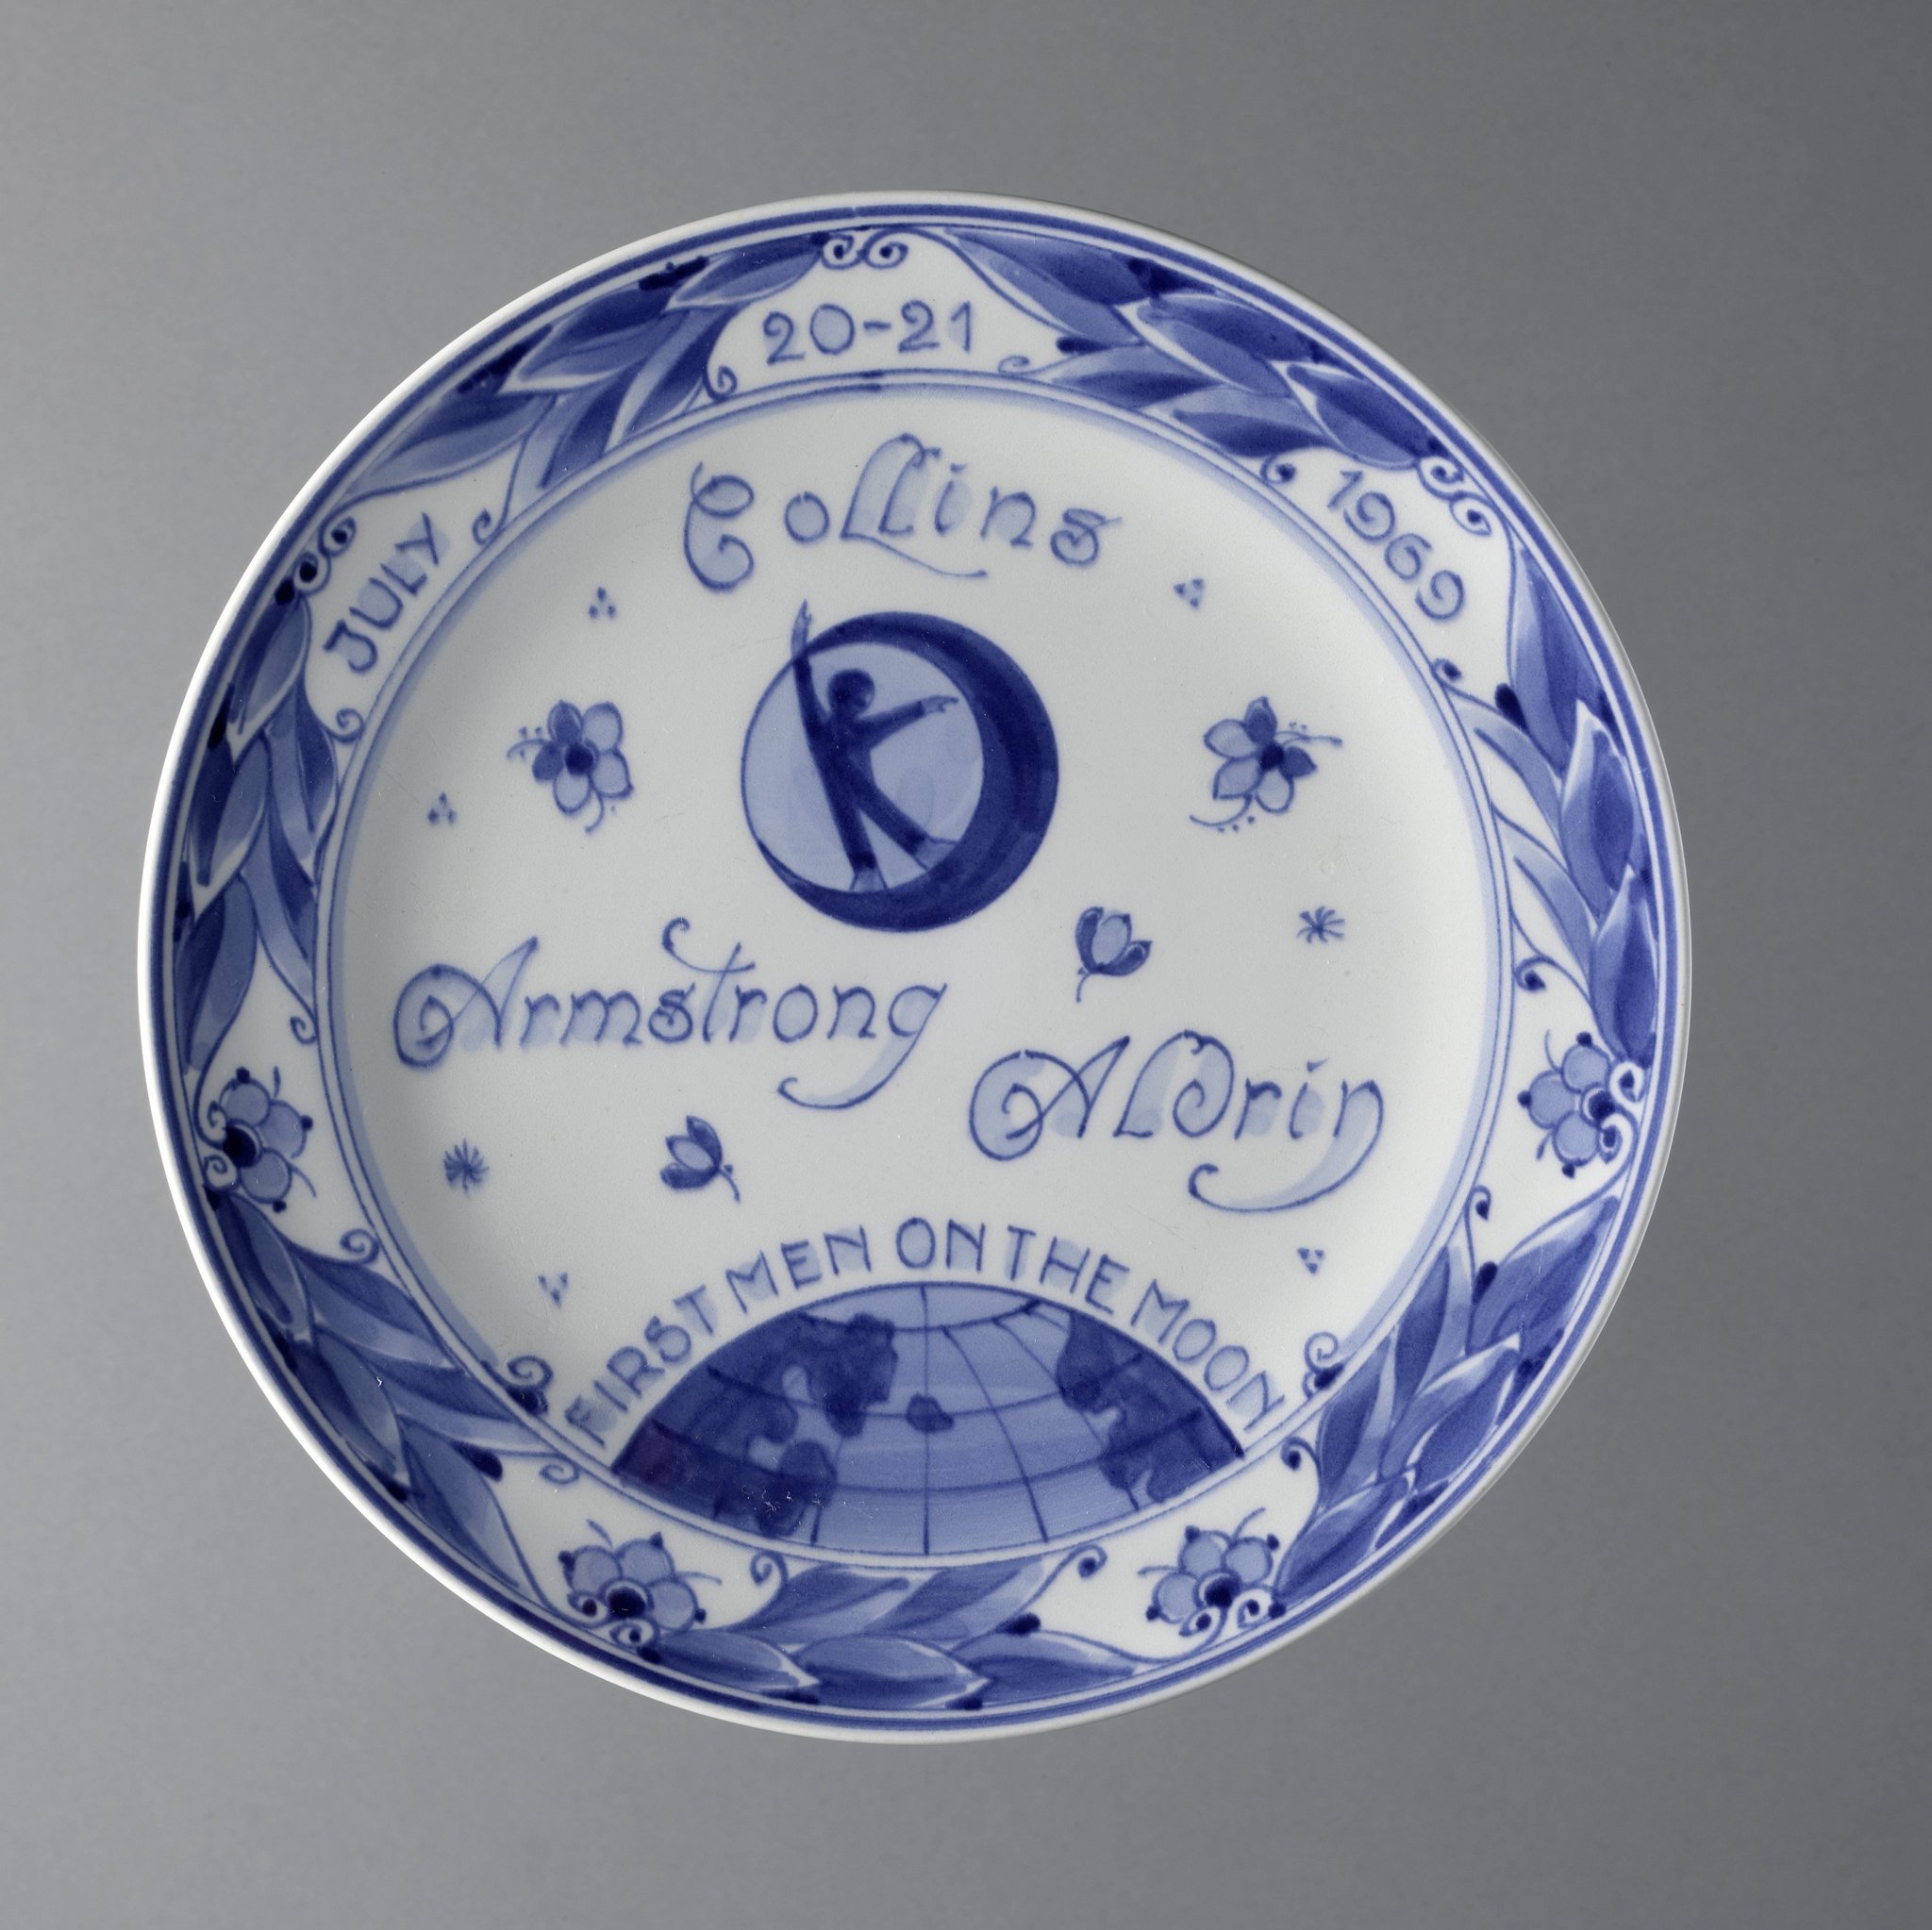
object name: herinneringsbord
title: First men on the moon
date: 1969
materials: earthenware, glaze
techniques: painted, vitrification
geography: delft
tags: united states of america, neil armstrong, moon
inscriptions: date: ‘JULY 20-21 1969’, factory mark: ‘JT Delft’, mark: ‘MDJ. CD. 1963’, title: ‘Collins Armstrong Aldrin FIRST MEN ON THE MOON’, label: ‘2308 FIRST MEN ON THE MOON 103.75’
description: Bord, blauw geschilderd met afbeelding van een mannetje op een halve maan. Hieronder een deel van de wereld. Met opschrift. Achterzijde twee blauwe randen en twee gaatjes met ijzerdraad om bord op te hangen. Gemerkt en voorzien van etiket.